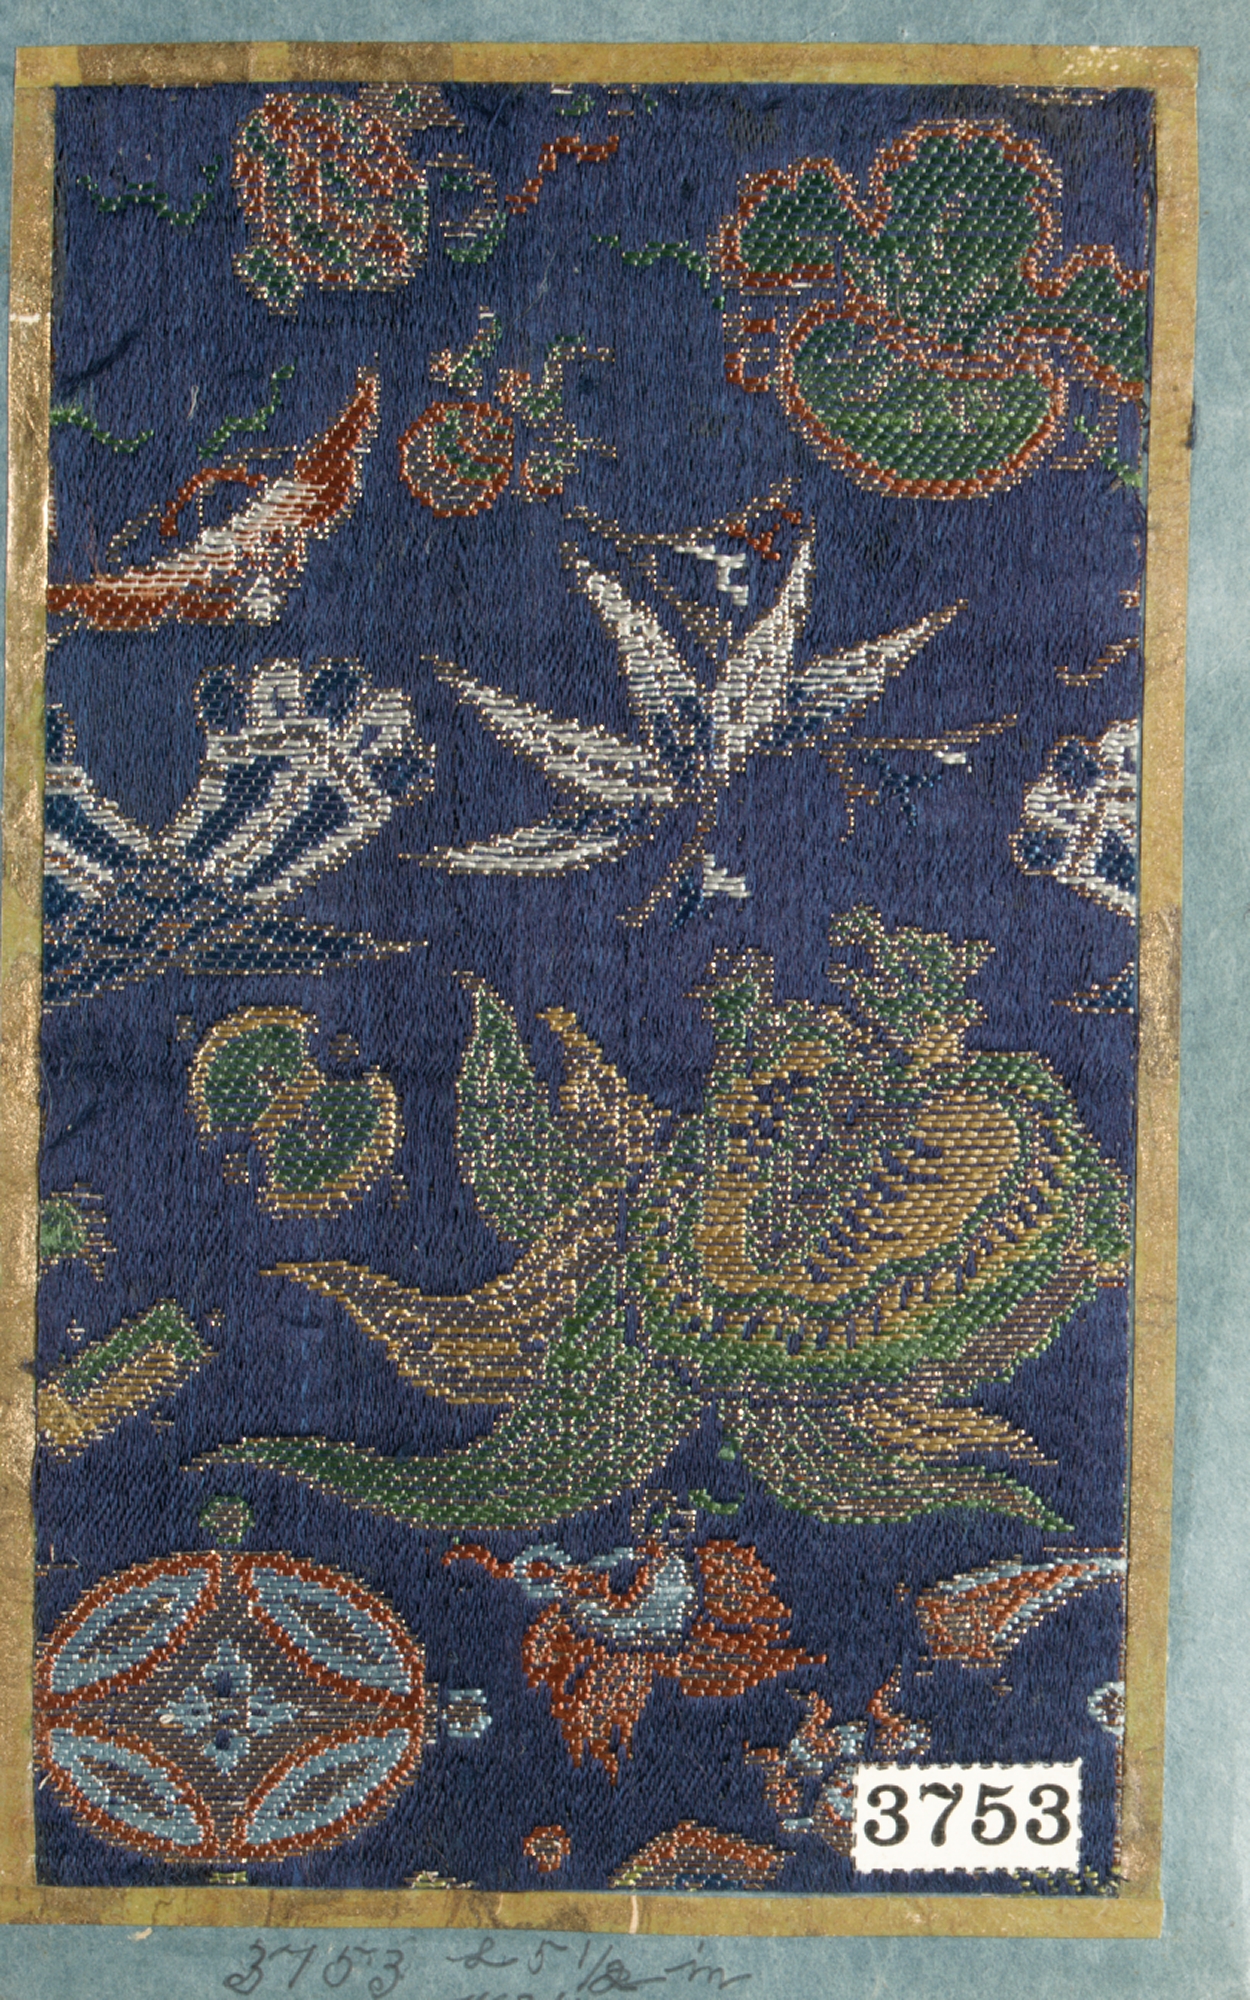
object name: sample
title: Textile Sample from Sample Book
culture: japanese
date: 1801-1900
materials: silk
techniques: tapestry